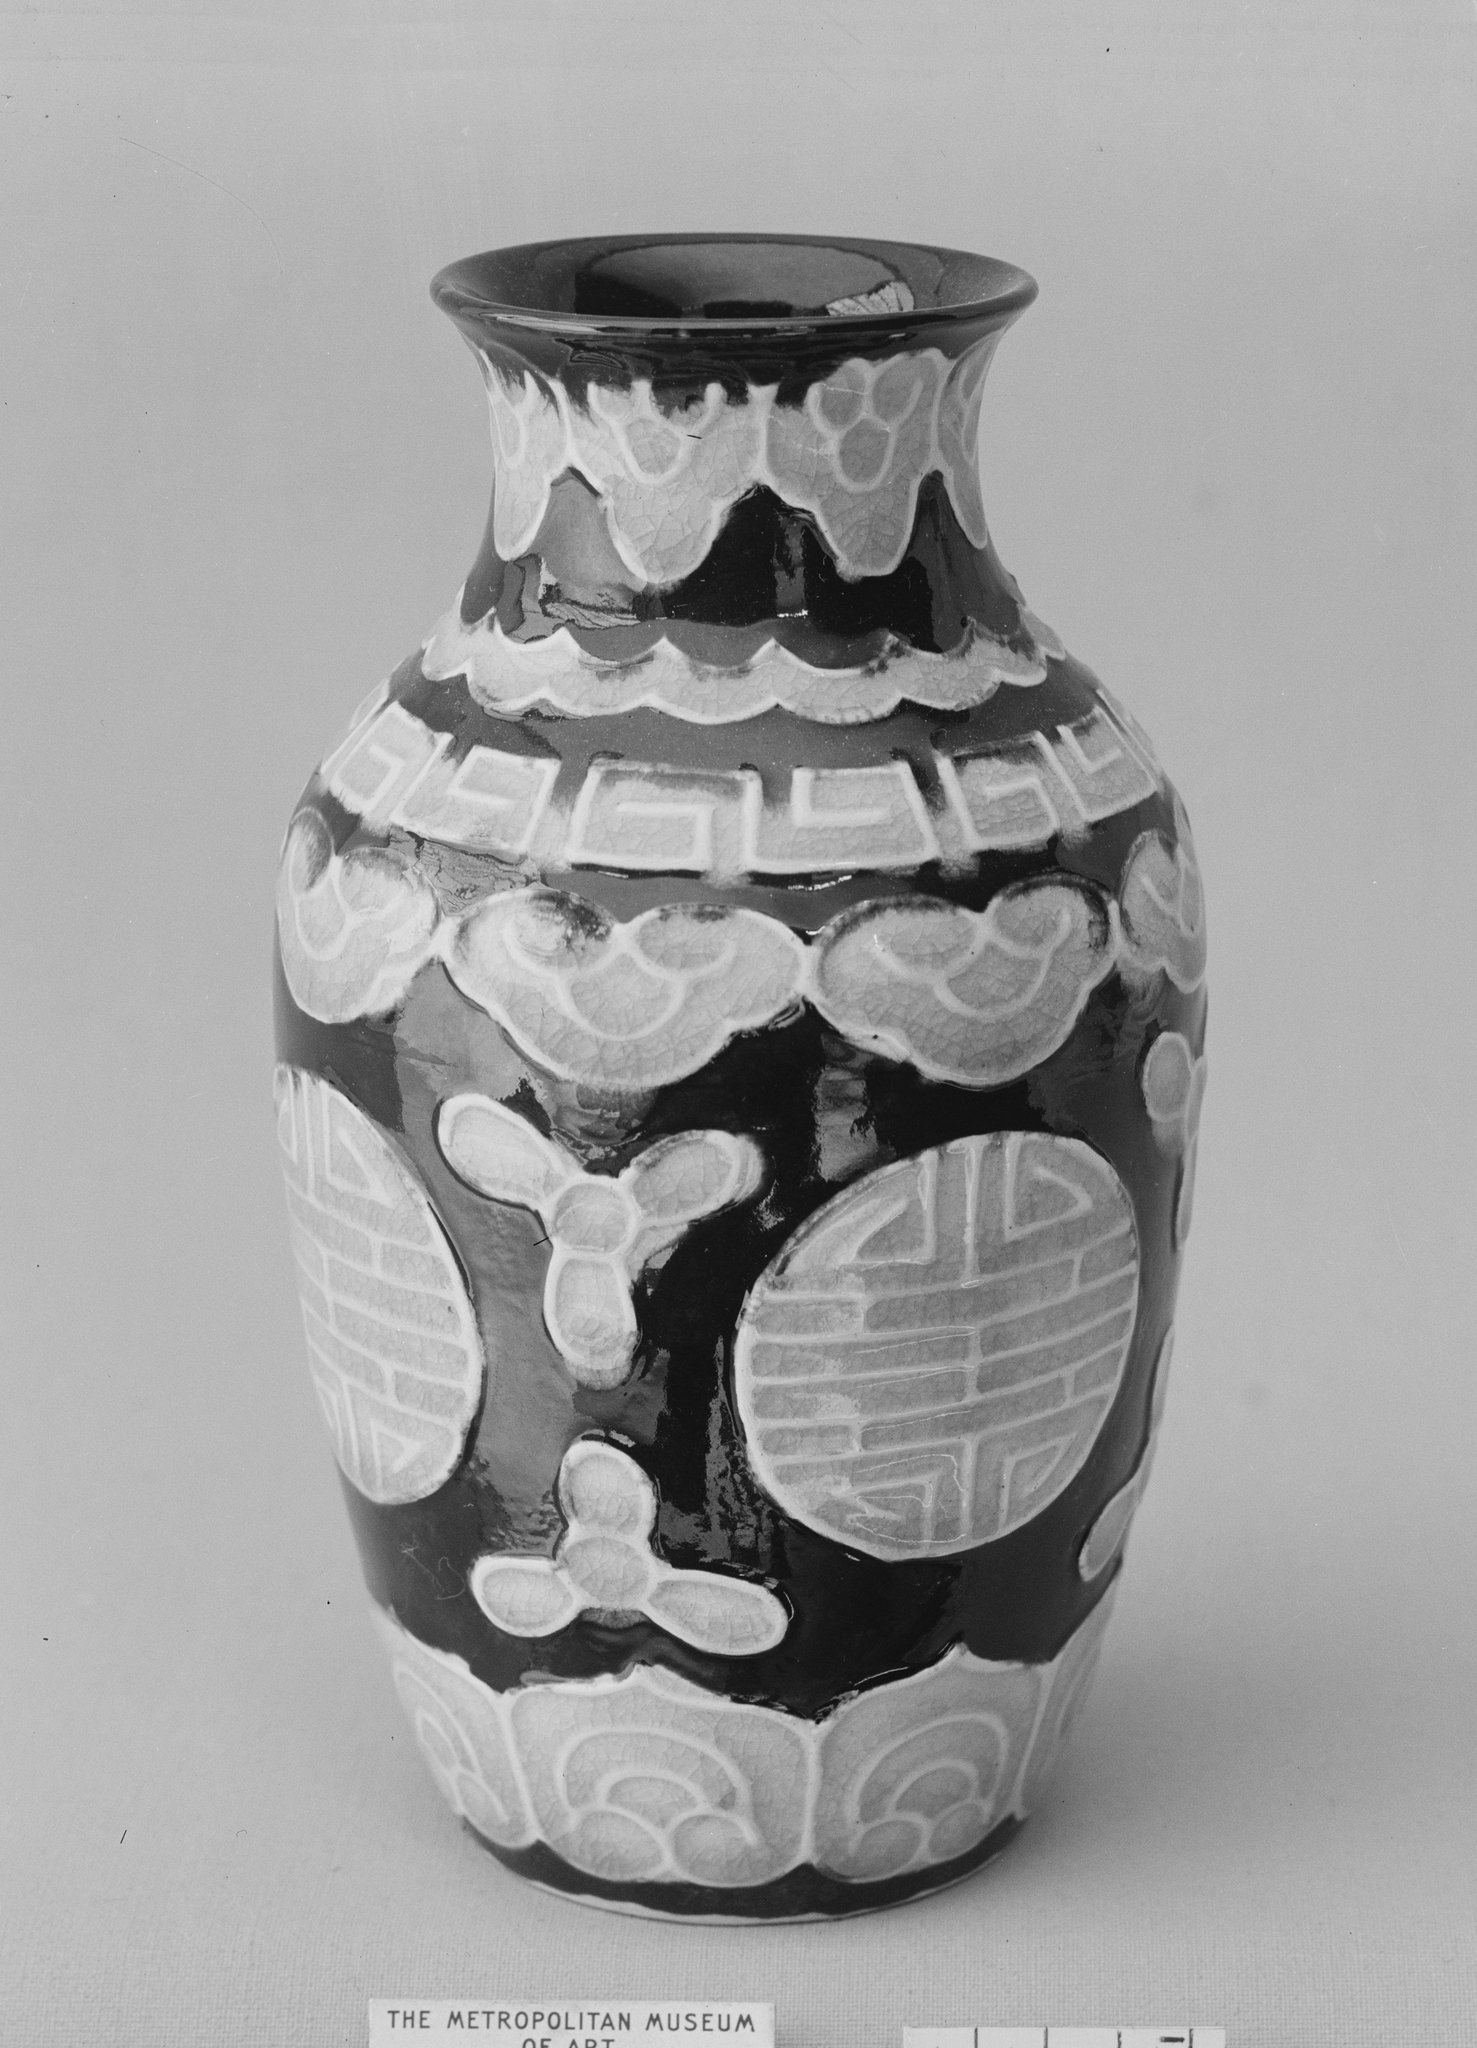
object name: vase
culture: japanese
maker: eiraku hozen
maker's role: artist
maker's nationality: japanese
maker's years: 1795-1854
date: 1801-1900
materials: clay, glaze